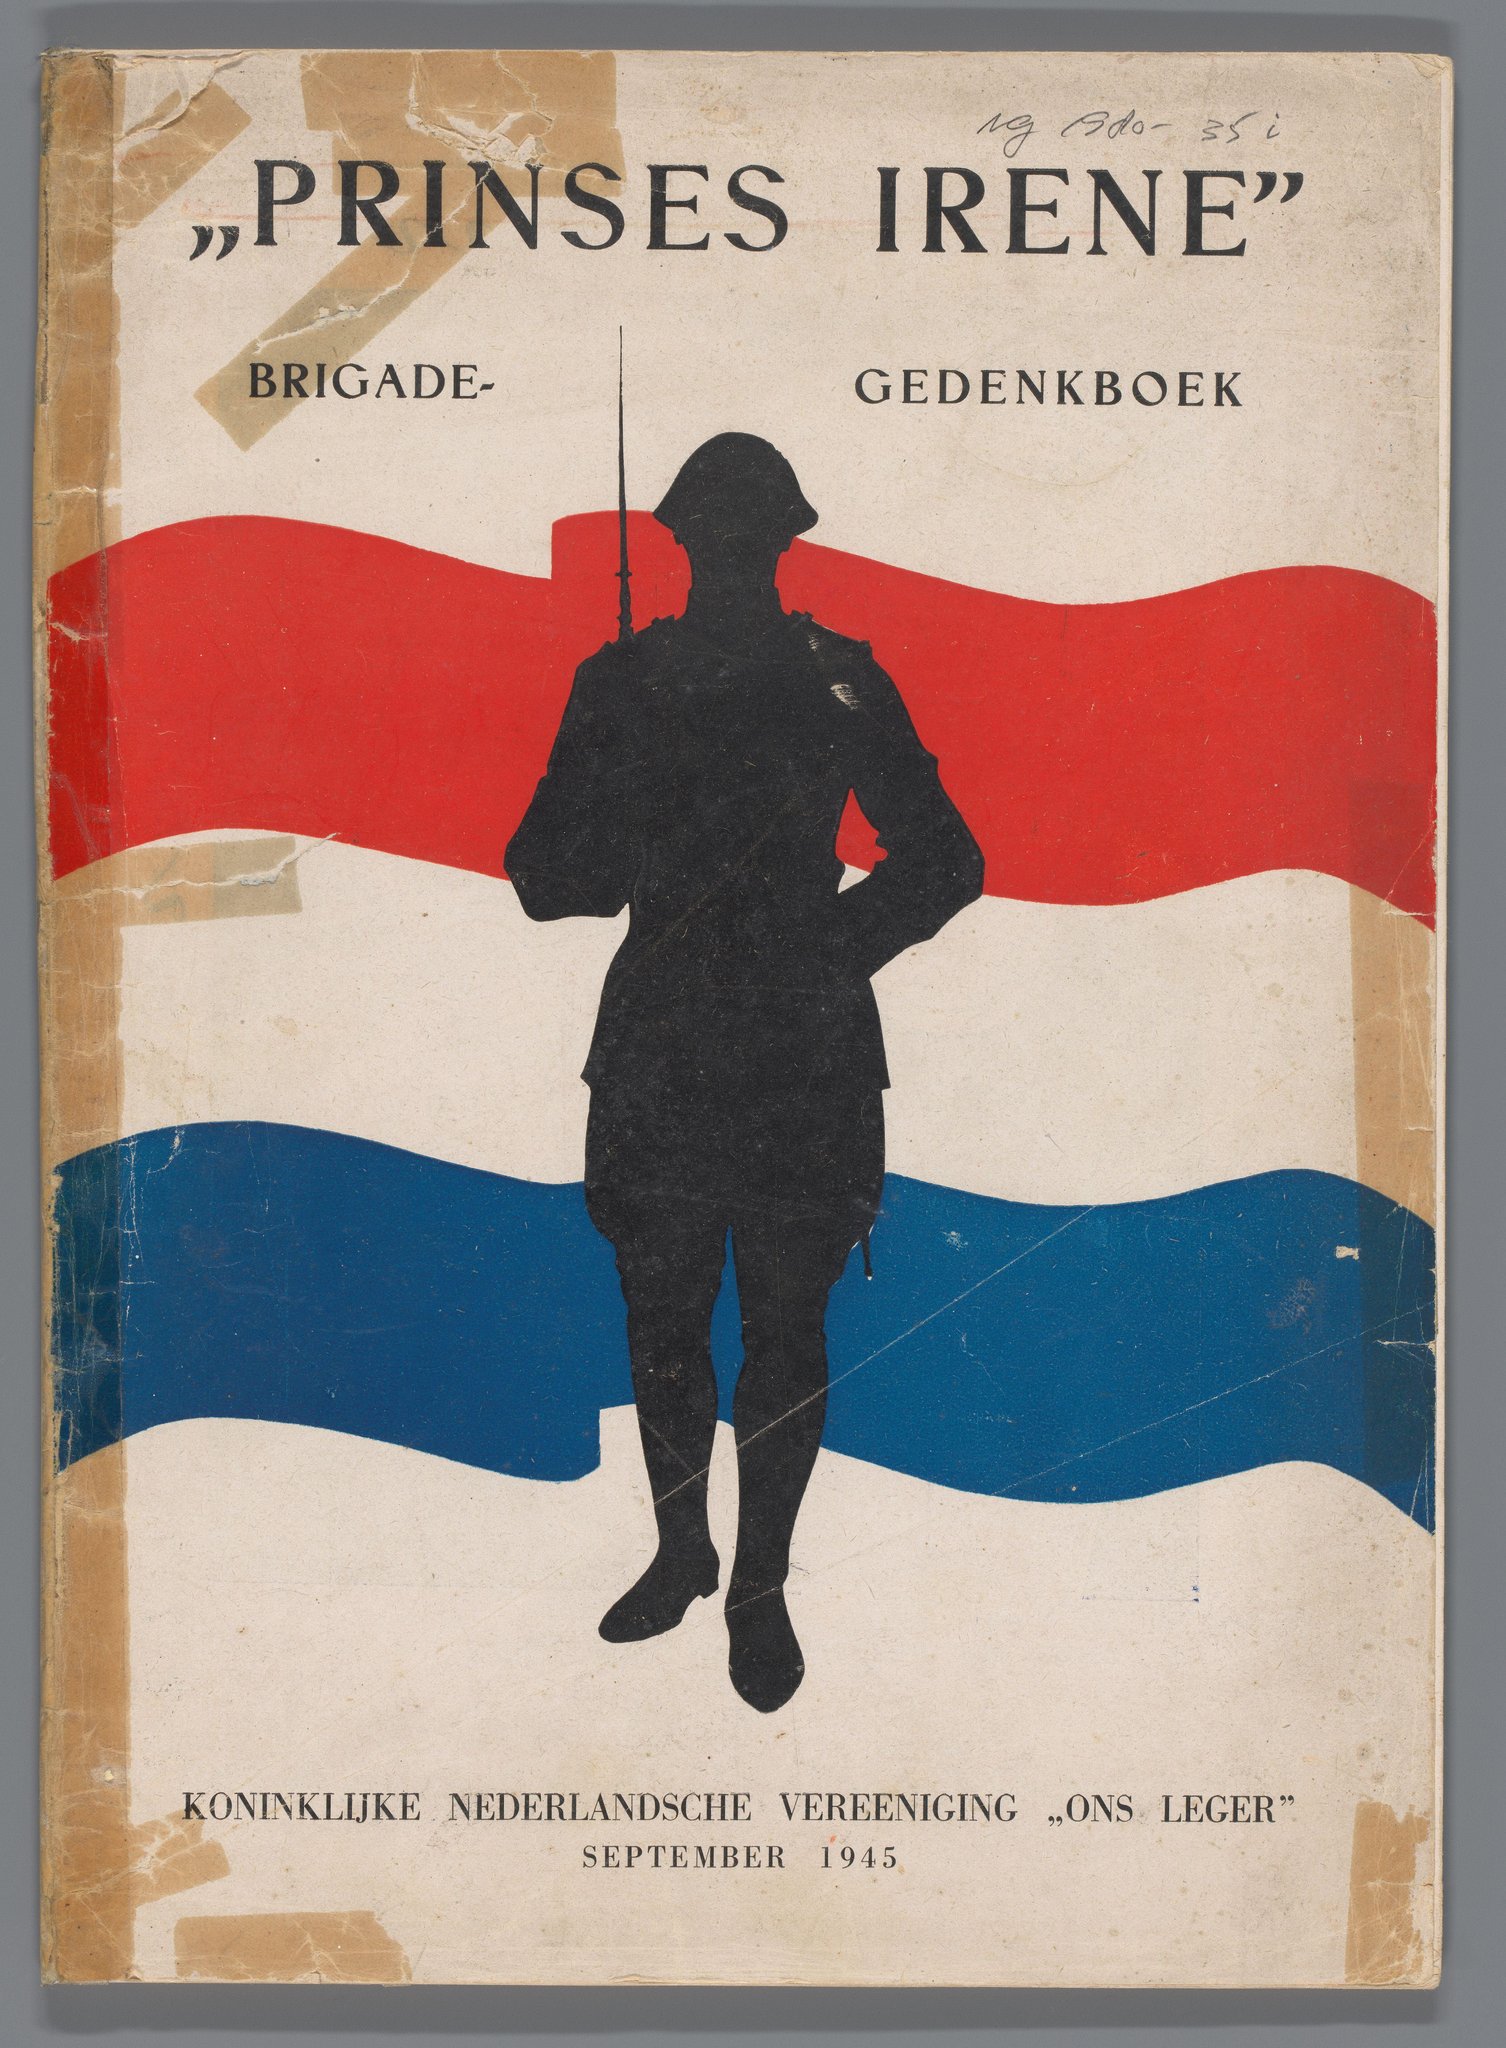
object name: book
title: Prinses Irene: brigade-gedenkboek Koninklijke Nederlandsche Vereeniging "Ons Leger"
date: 1909-1945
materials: paper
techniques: printing, sewing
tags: netherlands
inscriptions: date